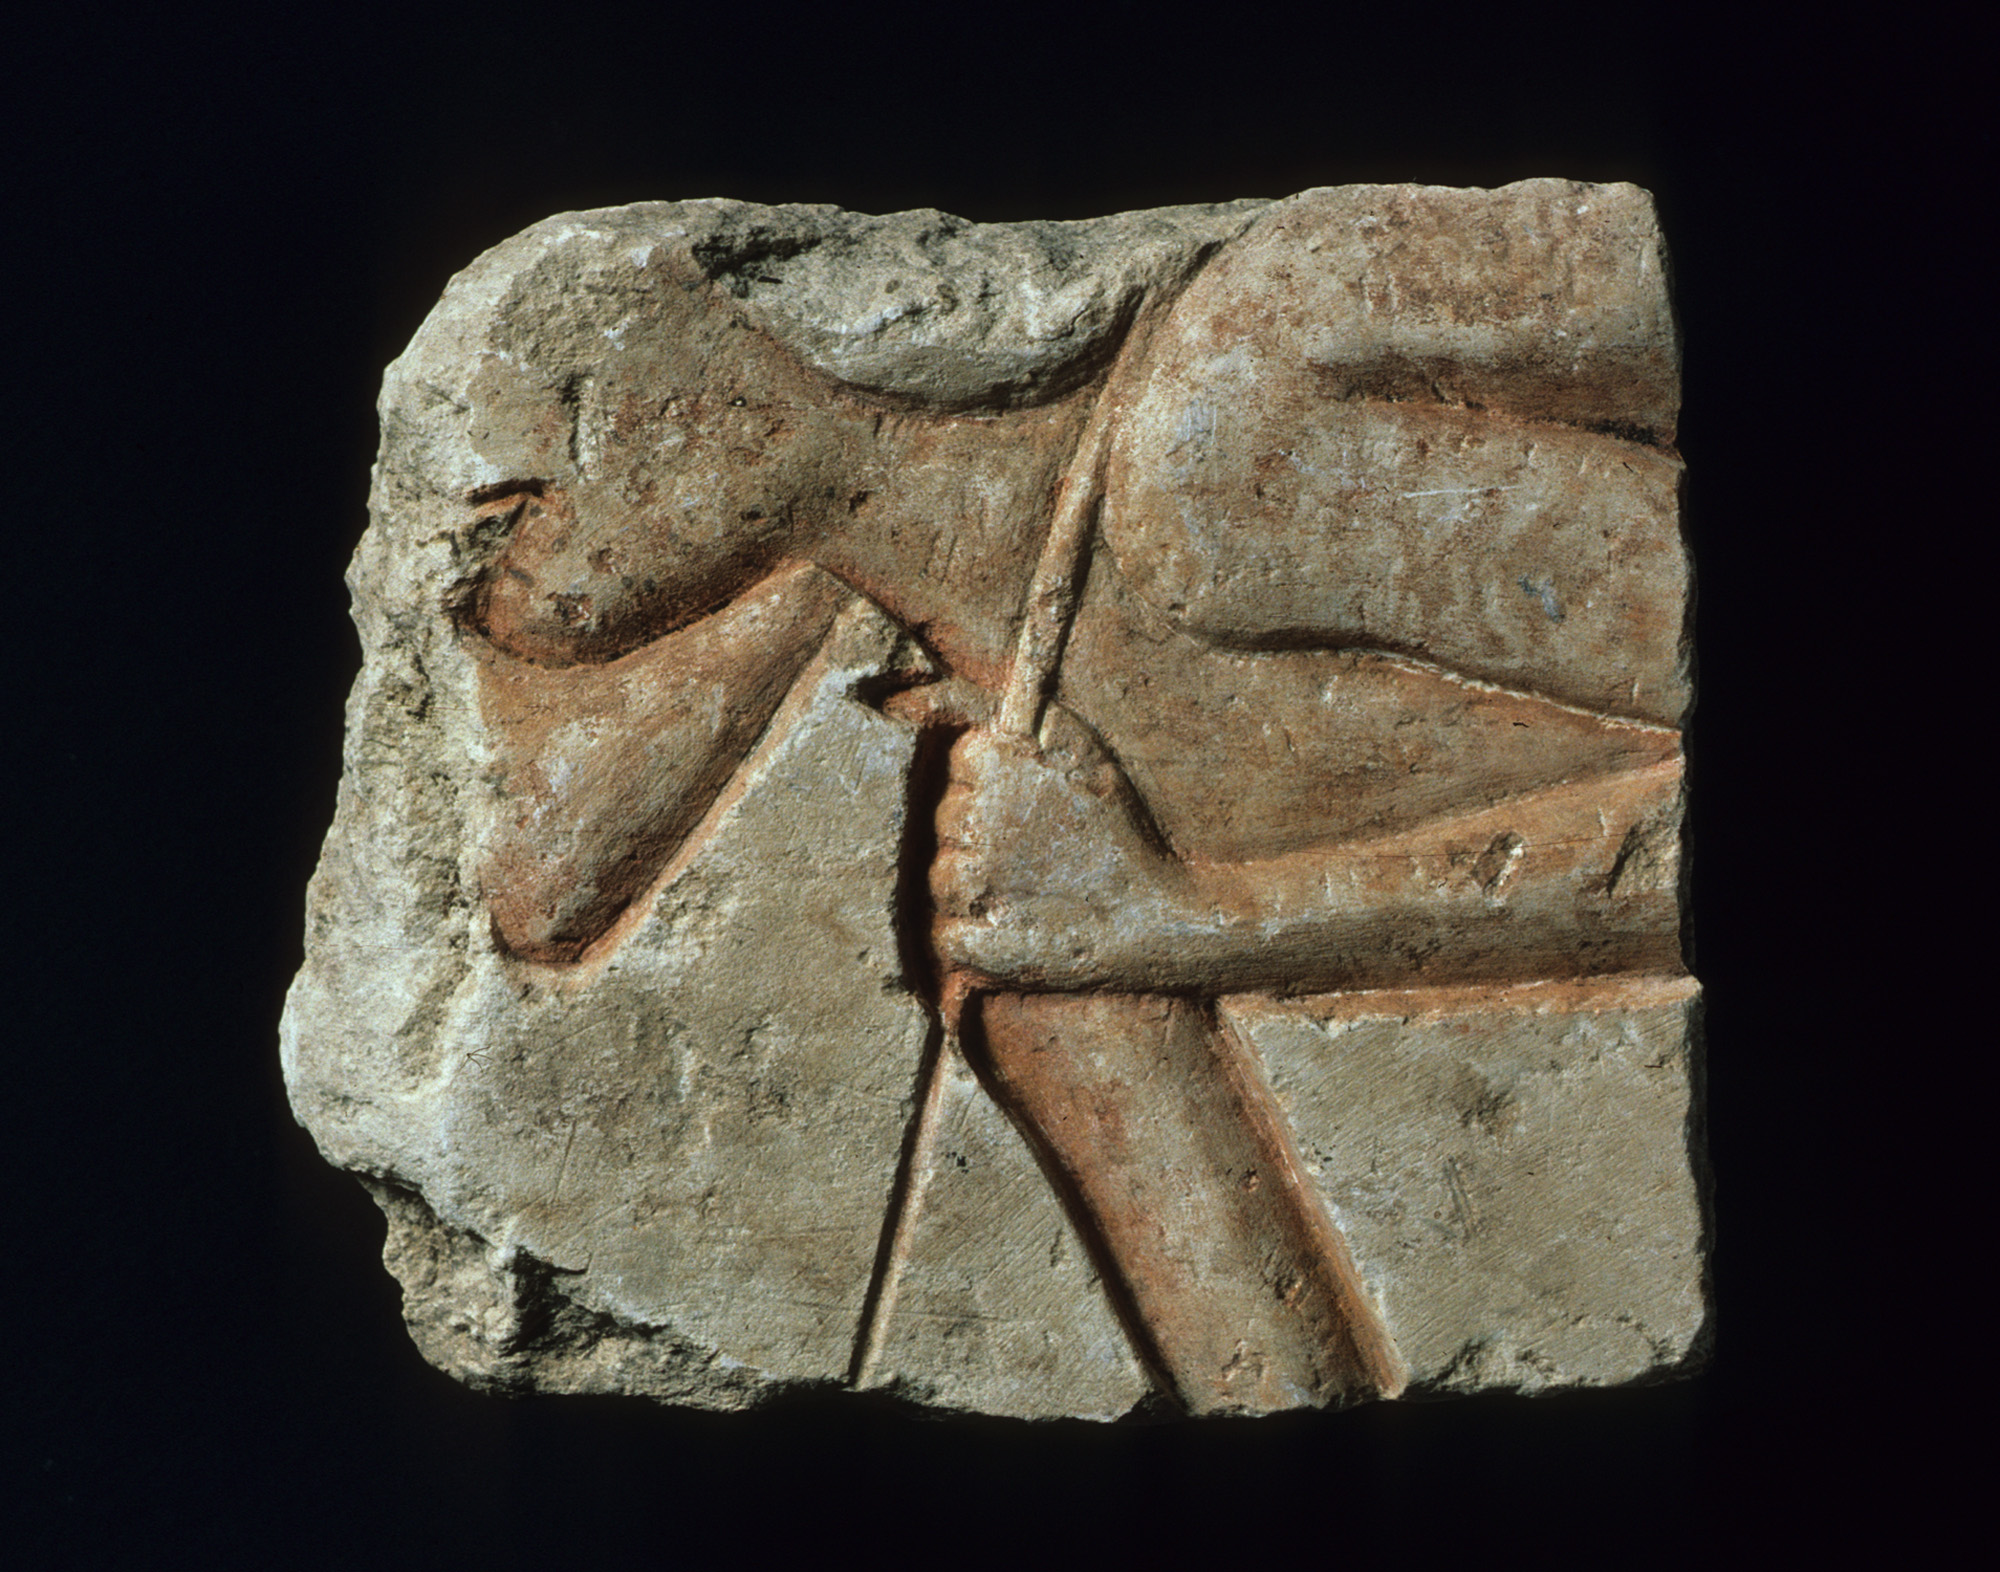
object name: talatat, stooped workman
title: Relief with a stooped workman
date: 1353-1336 BCE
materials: limestone, paint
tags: human figures